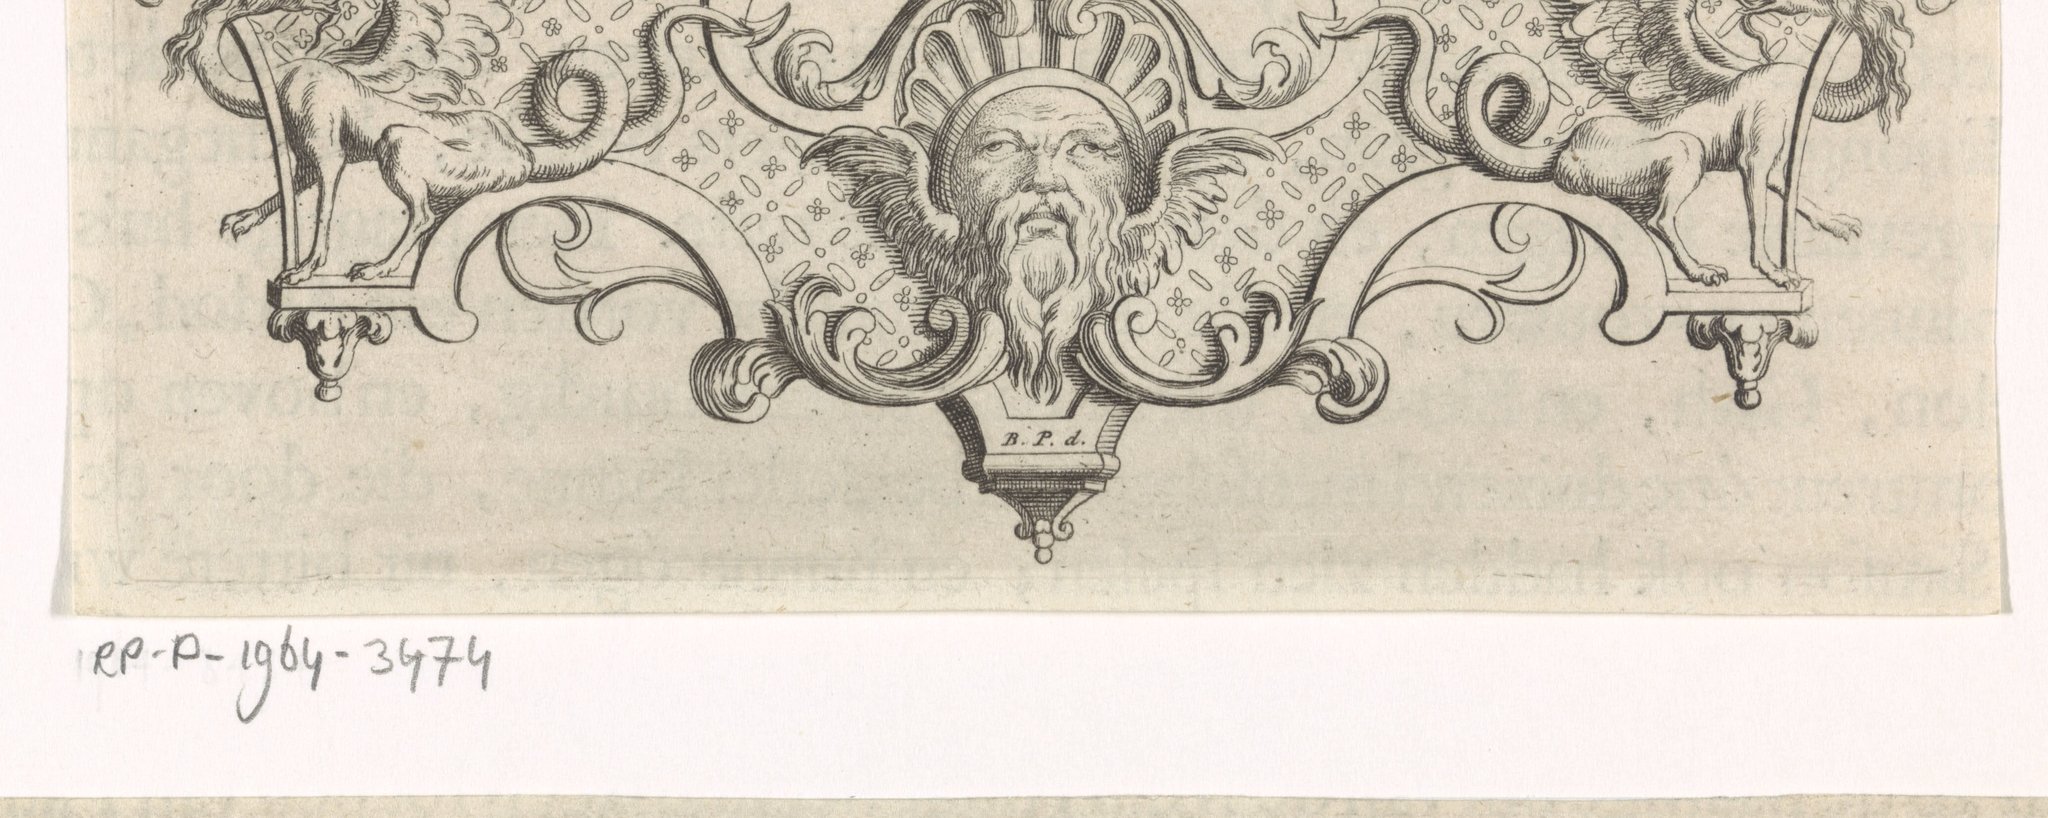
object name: print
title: Vignet met een mascaron, rolwerk en hybride wezens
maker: bernard picart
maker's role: draughtsman, print maker, publisher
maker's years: 1673-1733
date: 1683-1733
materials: paper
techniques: etching, letterpress printing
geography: amsterdam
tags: ornament ~ hybrid beings; human and animal forms mixed, mask, mascaron ~ ornament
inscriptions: collector's mark: Lugt 2228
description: Prent oorspronkelijk bedoeld voor: Figures de la Bible. Amsterdam, Bernard Picart, 1720. Prent ook gebruikt in: Taferelen der voornaamste geschiedenissen van het Oude en Nieuwe Testament (...) door de vermaarde kunstenaars Hoet, Houbraken, en Picart getekent (...) en met beschrijvingen uitgebreid. Den Haag: Pieter de Hondt, 1728. Prent kan mogelijk ook zijn gebruikt in andere bijbels.